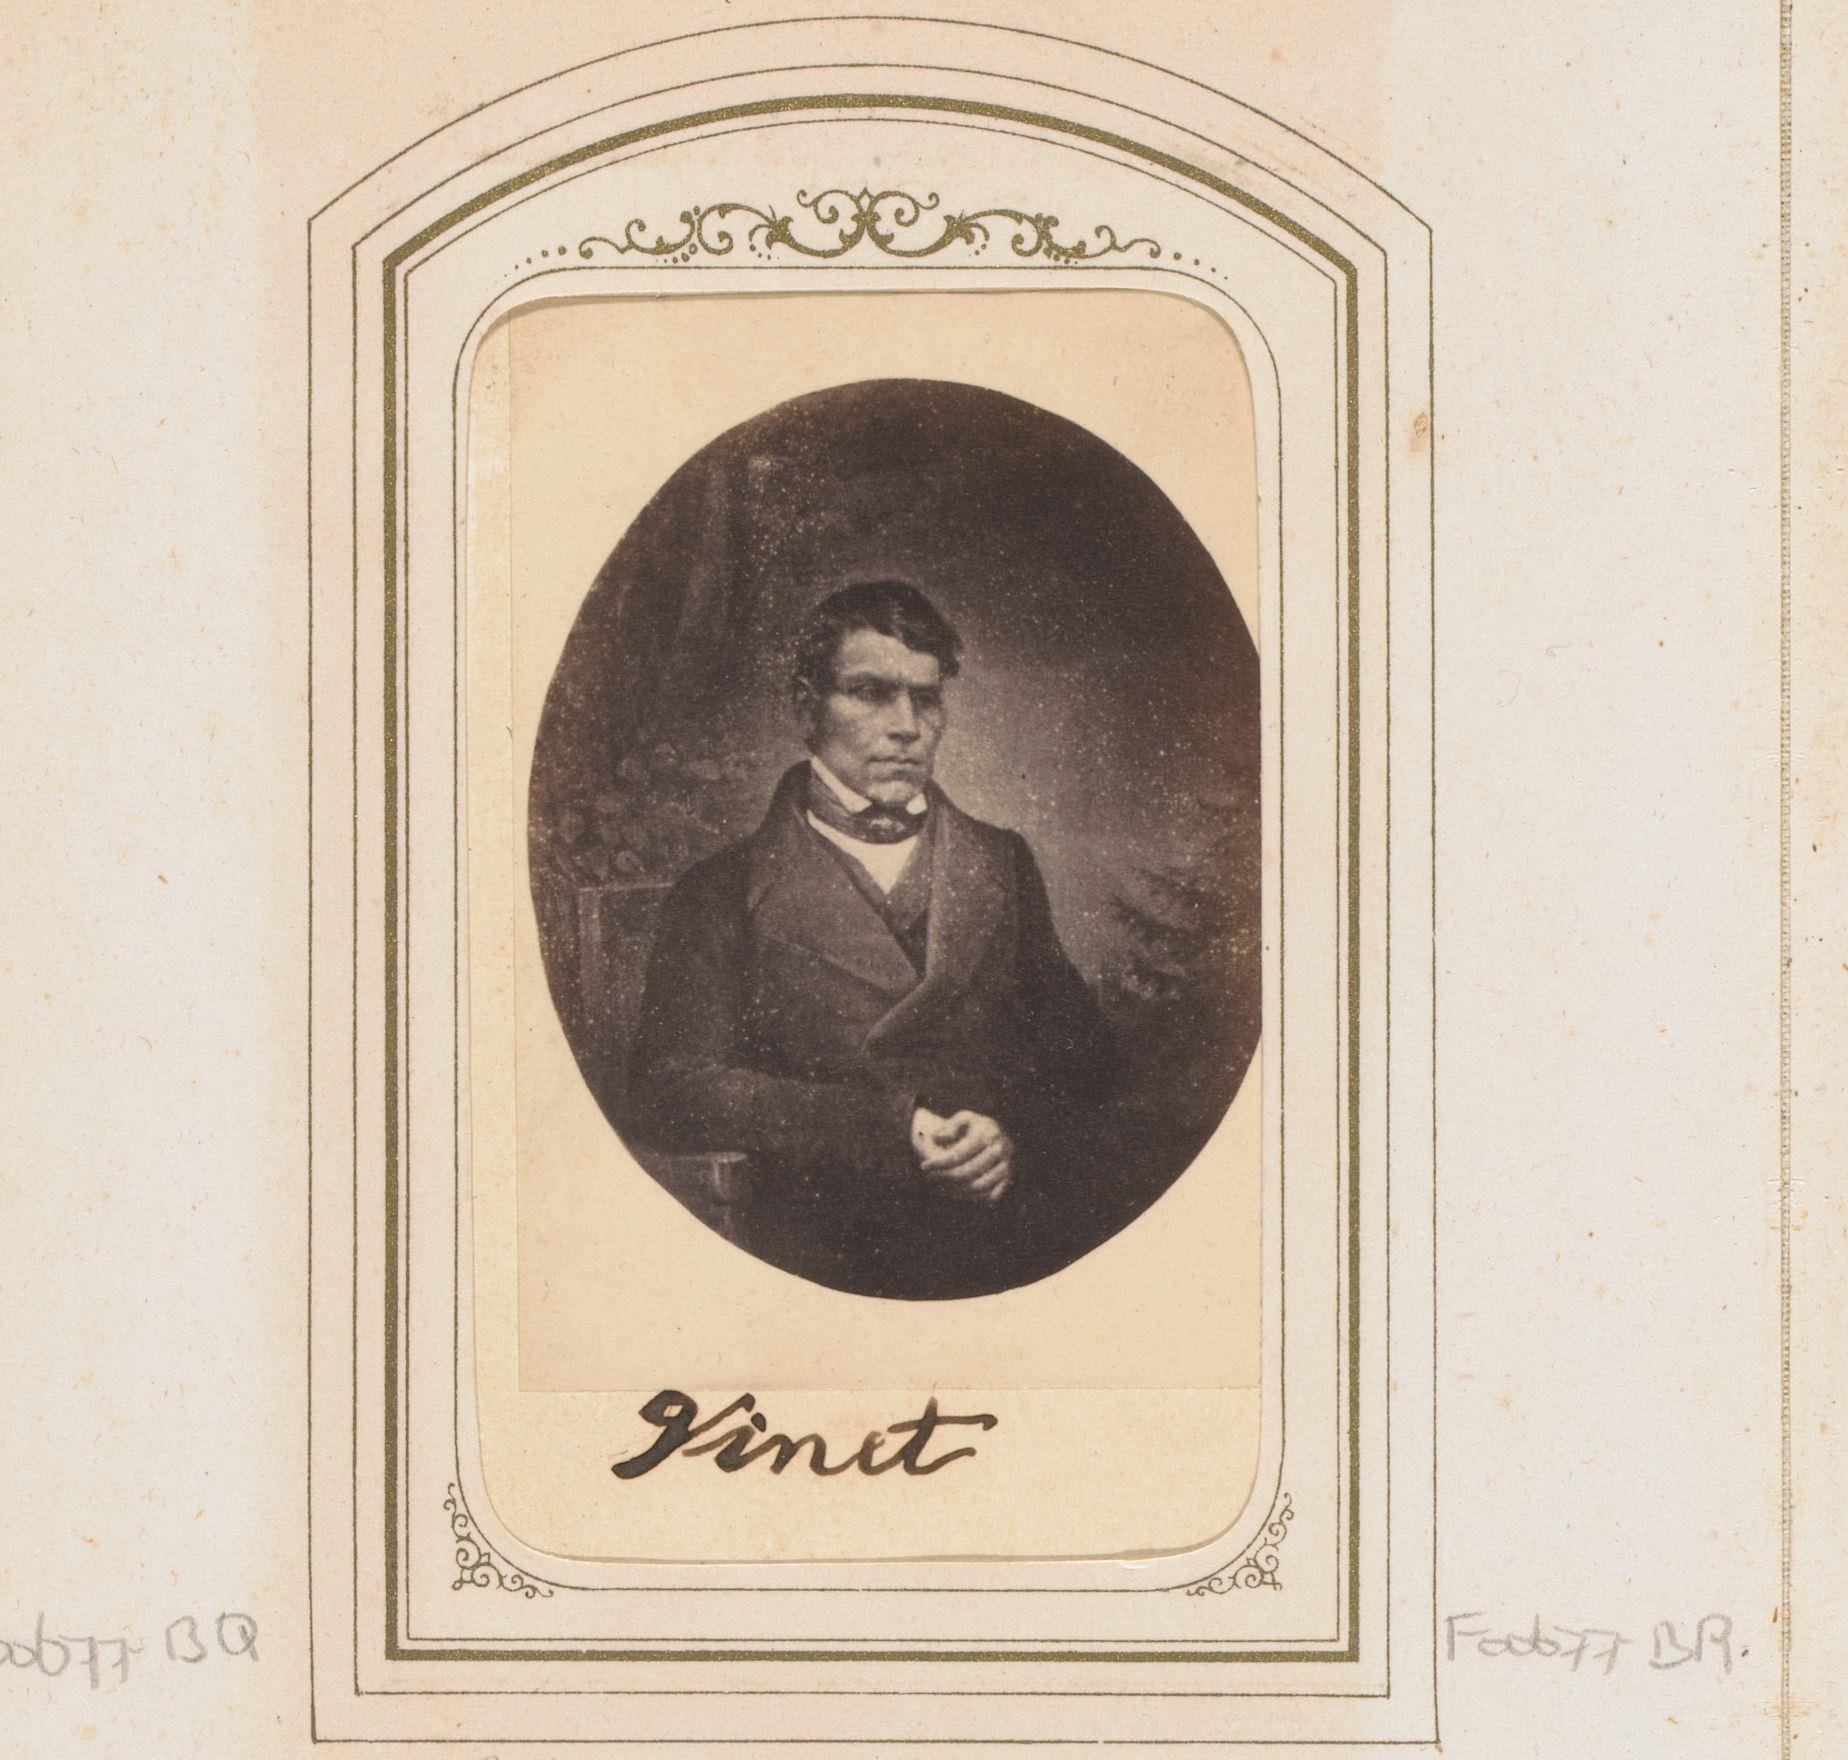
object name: carte de visite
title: Portret van Alexandre Rudolphe Vinet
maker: sues-ducommon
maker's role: fotograaf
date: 1850-1870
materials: cardboard, photographic support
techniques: albumen print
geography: geneva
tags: theologian, historical persons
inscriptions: name: ‘Vinet’, annotation: ‘A.Vinet 1797-1847/ Fr. Zwitsers schrijver en theoloog’, inscription: ‘M. SUES DUCOMMON/ ÉDITEUR/ GENEVE/ Grande Rue No [..]’